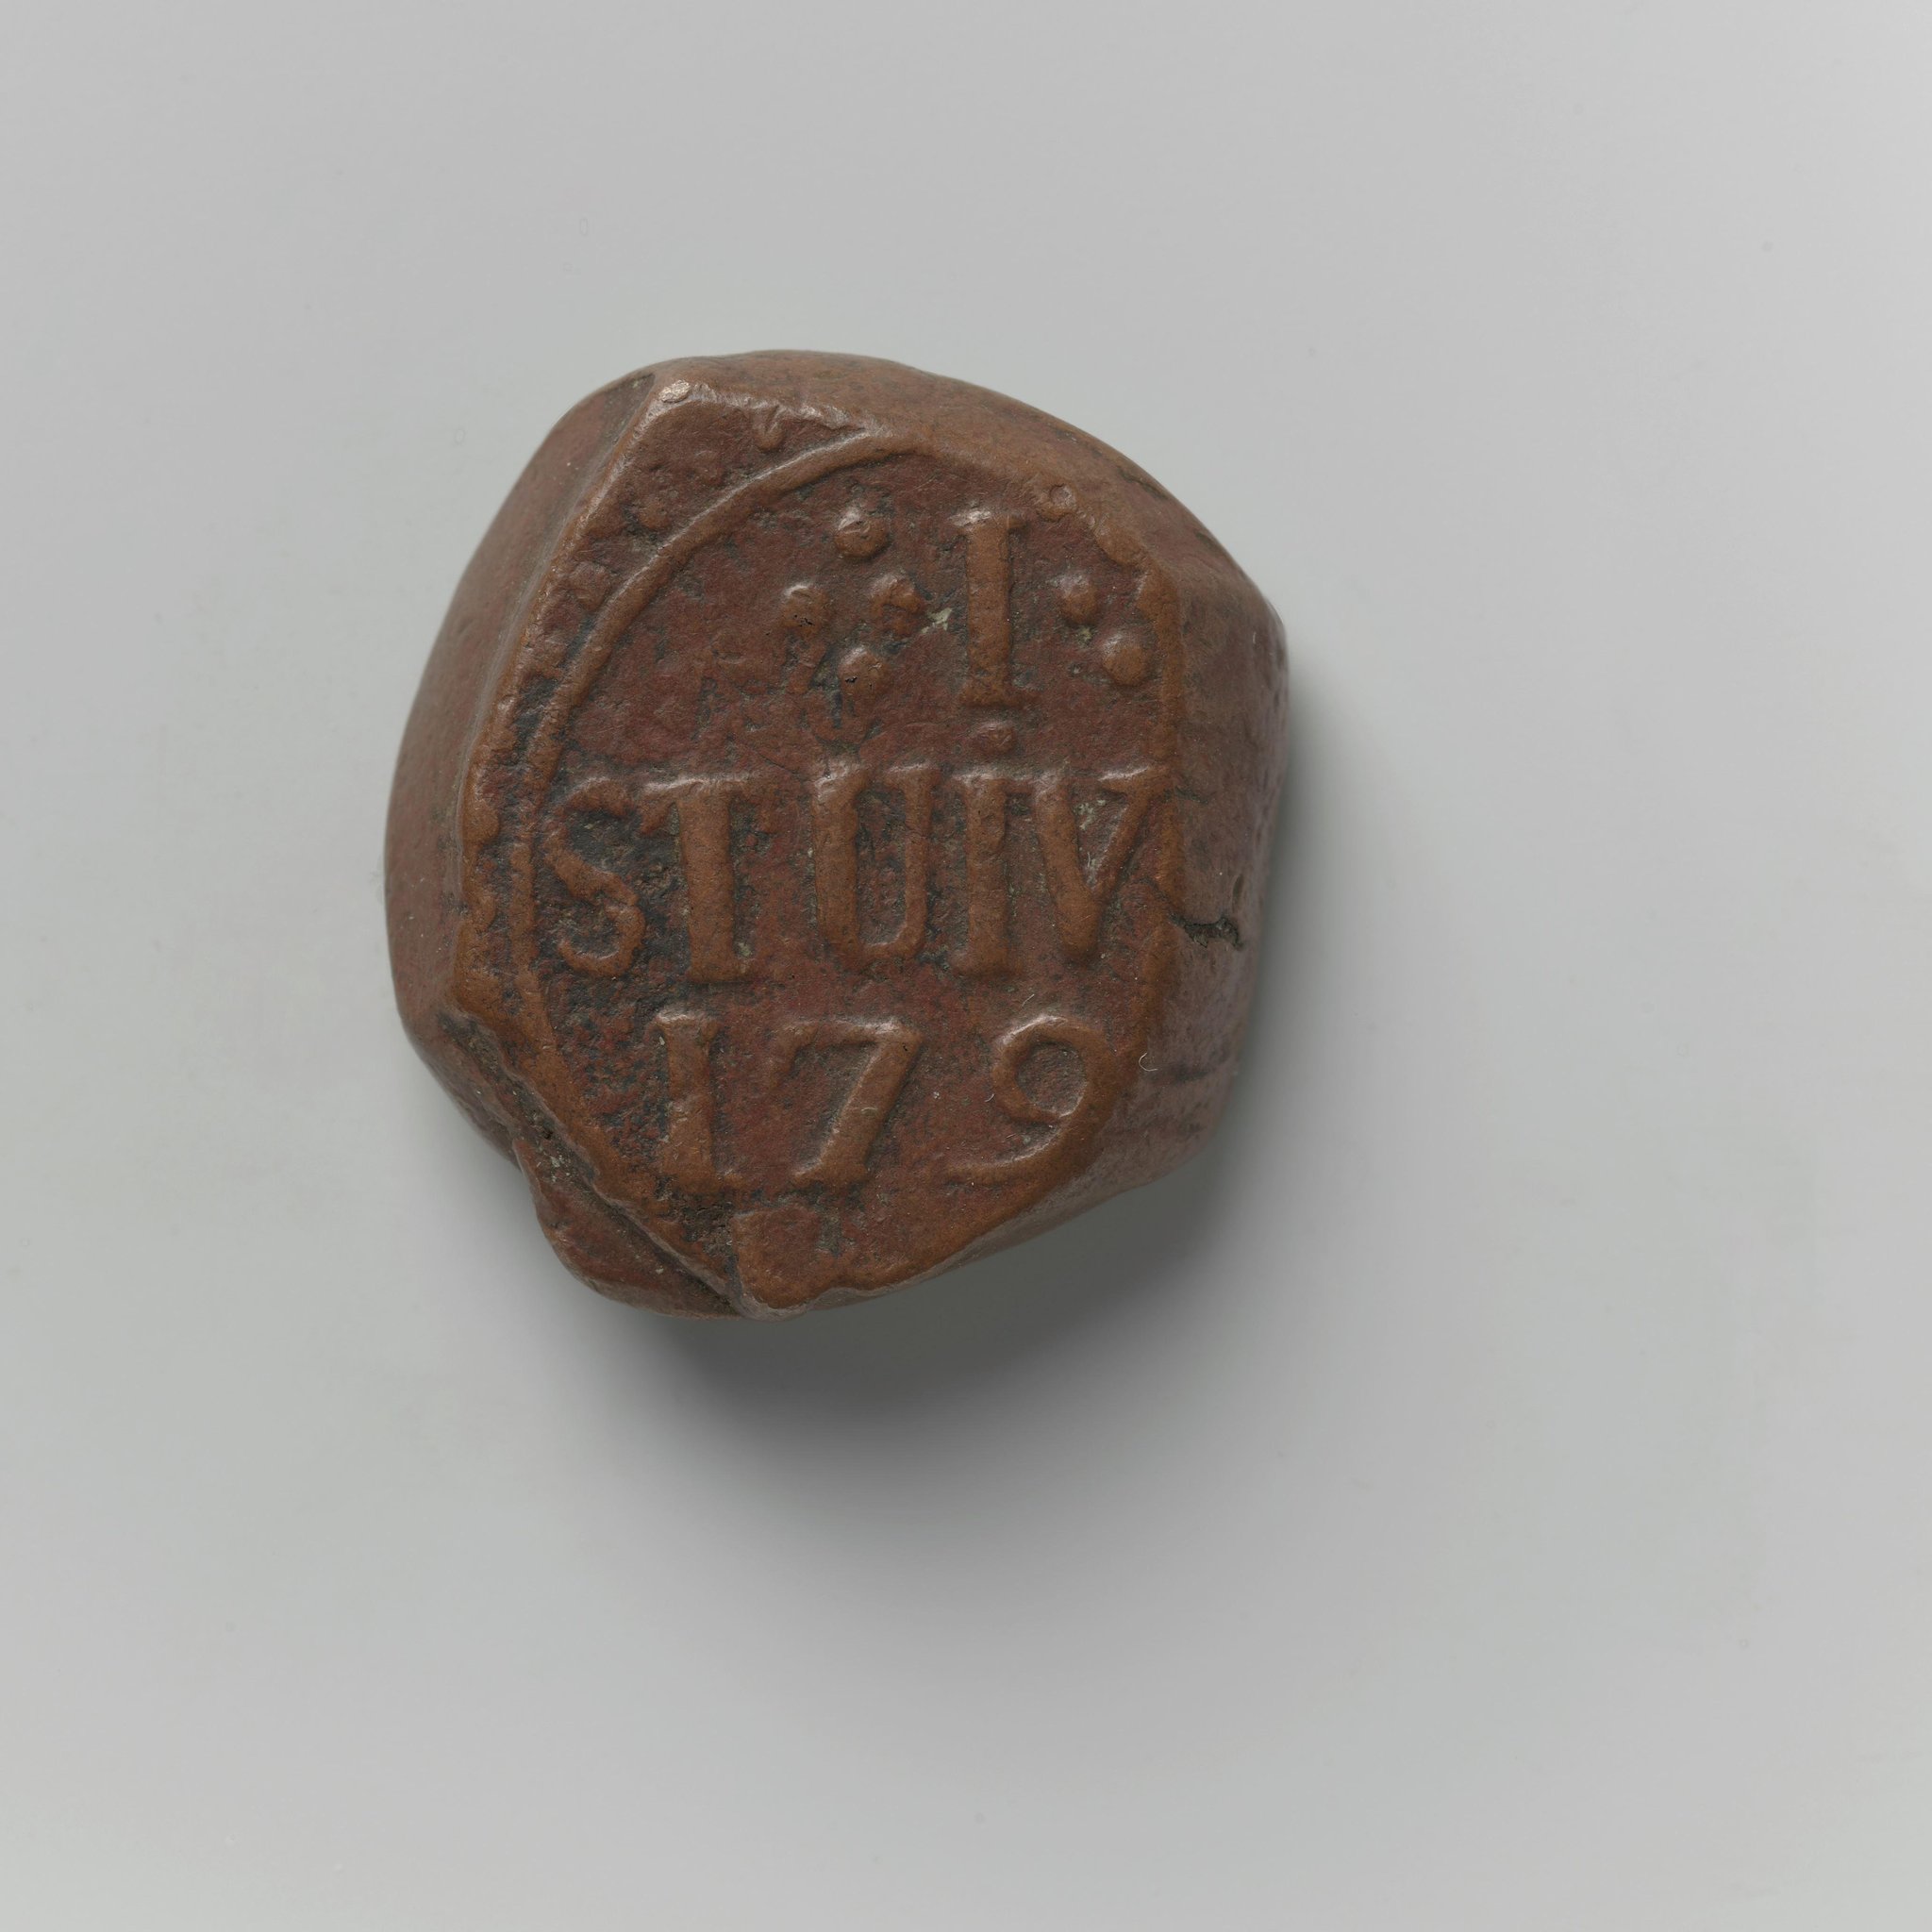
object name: coin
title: Stuiver van Ceylon, 179[?]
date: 1790-1795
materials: copper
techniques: striking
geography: colombo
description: Koperen munt. Voorzijde: monogram van de VOC, waarboven letter C. Keerzijde:eenregelig opschrift: waarde-aanduiding stuiver, waarboven I en waaronder gedeeltelijk zichtbaar jaartal. Gladde rand.